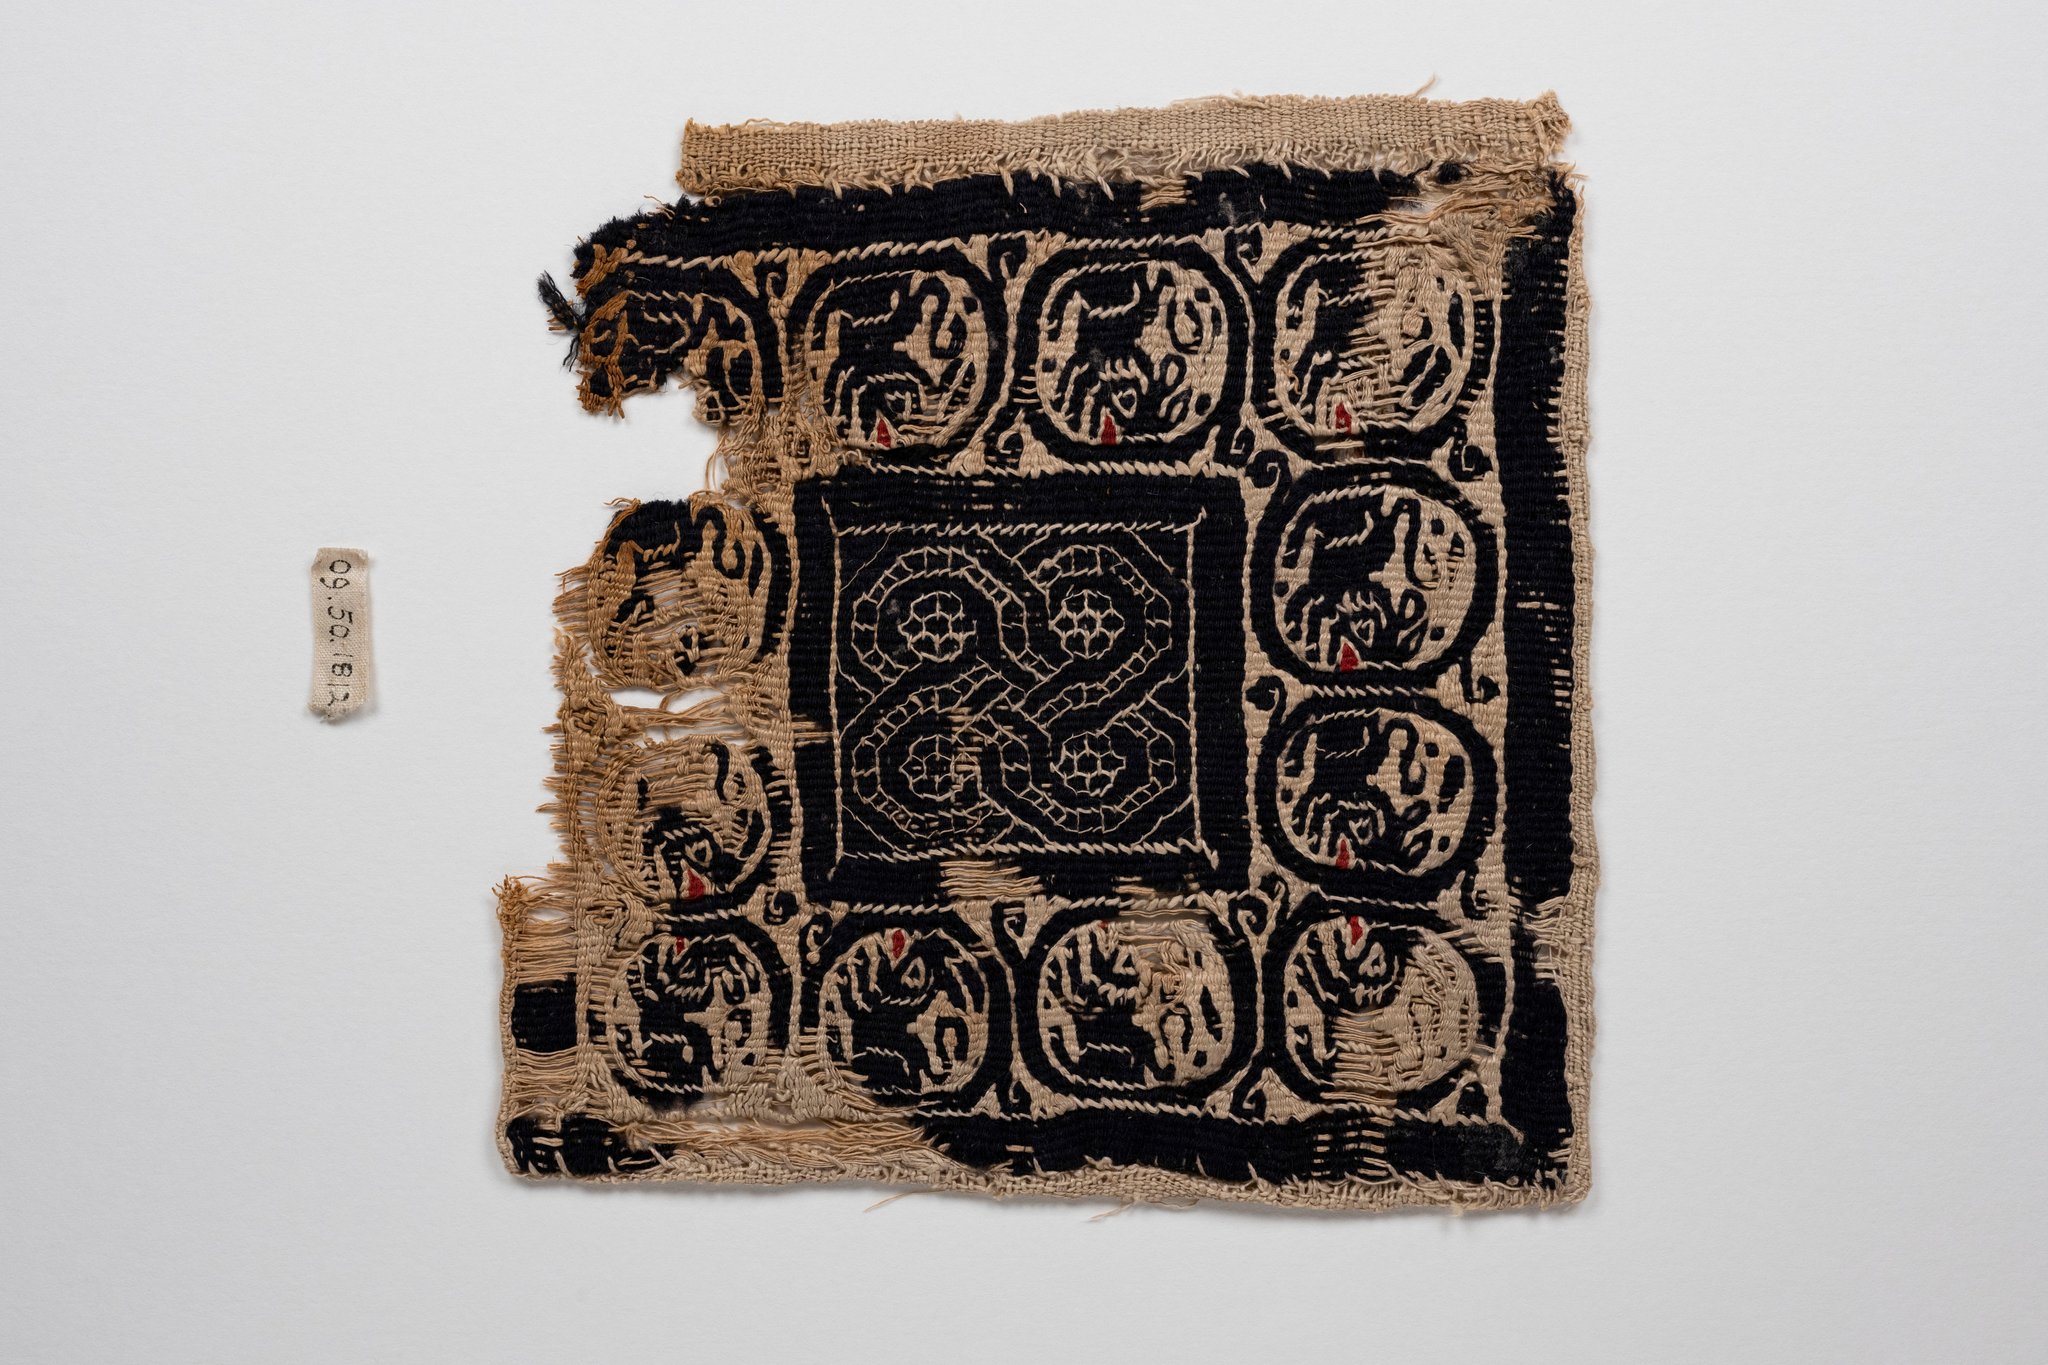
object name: square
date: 301-500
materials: linen, wool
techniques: weave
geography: egypt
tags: animals